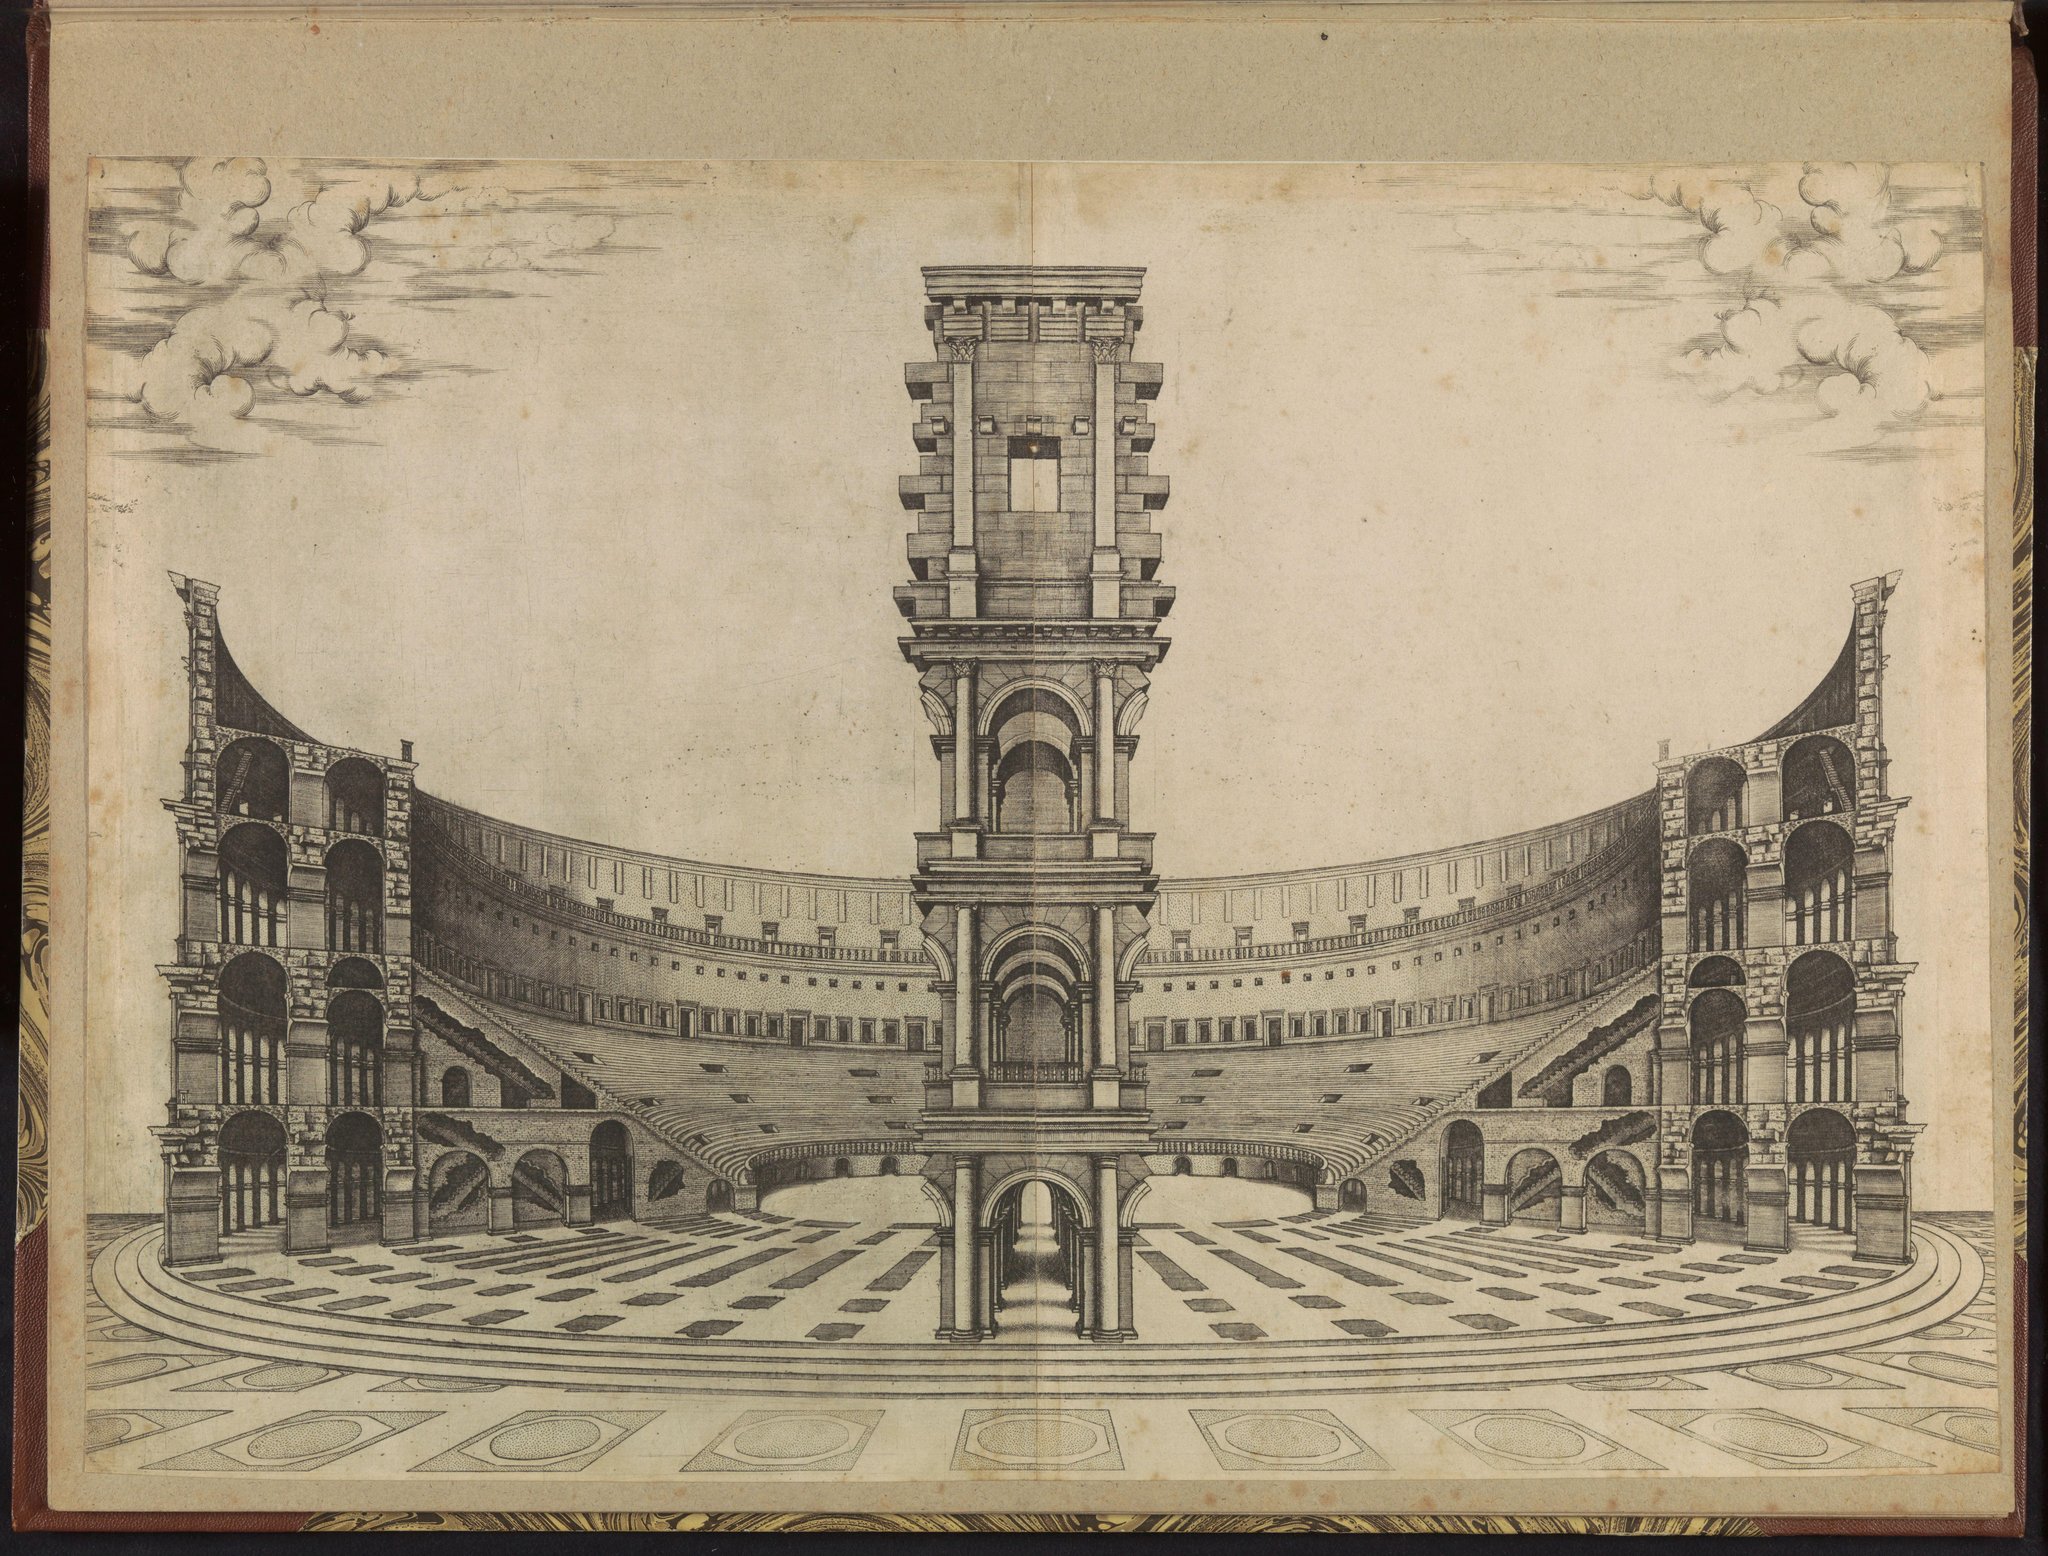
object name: print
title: Speculum Romanae Magnificentiae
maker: Anonymous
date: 1500-1599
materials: paper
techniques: engraving, etching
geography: italy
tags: theatre (building) - aa - open-air performances, representation of real building (either existing or having existed)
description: Deze prent behoort tot het prentcorpus dat bekend staat als de ‘Speculum Romanae Magnificentiae’ (‘Spiegel van Romeinse pracht’). Dit corpus, bestaande uit prenten met voorstellingen van kunstwerken en gebouwen uit het antieke en het moderne Rome, vond zijn oorsprong bij uitgevers Antonio Salamanca en Antonio Lafreri. Deze twee buitenlandse uitgevers bundelden hun krachten te Rome in de periode 1553-1563. Hun prenten werden al snel razend populair bij toeristen en verzamelaars, die de prenten individueel of in grote groepen aanschaften. Grote groepen Speculum-prenten werden vaak op aanvraag samengebonden in albums. Er zijn verschillende Speculum-albums overgeleverd die allemaal verschillen van inhoud. Tussen 1573 en 1577 gaf Antonio Lafreri een speciale titelpagina uit (met de titel ‘Speculum Romanae Magnificentiae’) die mensen voor hun verzamelingen konden voegen. Het overlijden van Lafreri in 1577 betekende niet het einde van het corpus. Een groot deel van de koperplaten ging over op Claudio en Stefano Duchetti. De rest raakte verspreid over verschillende andere uitgevers. De populariteit van de Speculum-prenten wist nog geruime periode uitgevers te inspireren tot het laten maken van kopieën en het toevoegen van nieuwe prenten aan het corpus.